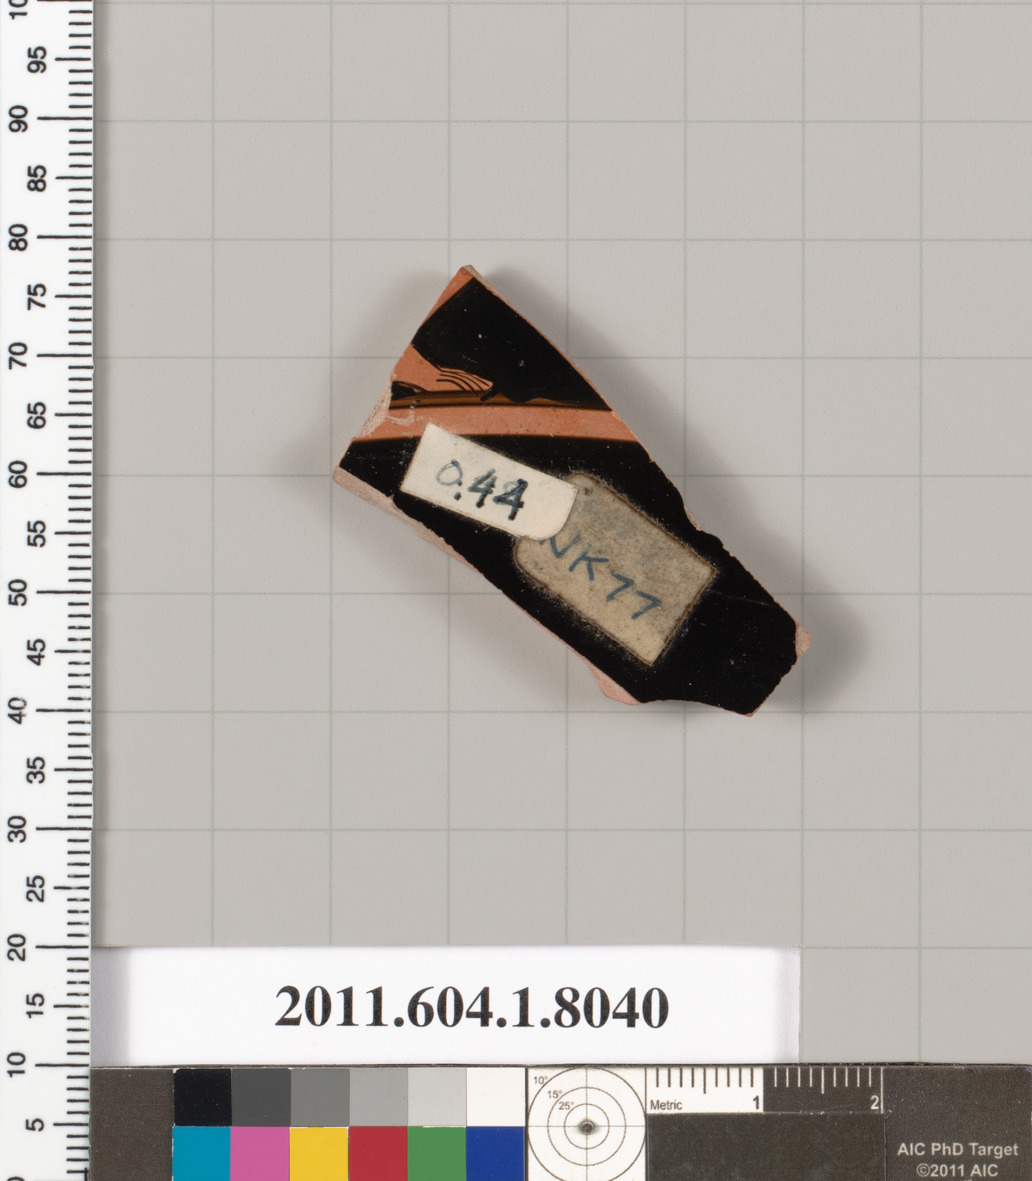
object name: kylix fragment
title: Terracotta fragment of a kylix (drinking cup)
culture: greek, attic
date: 510-500 BCE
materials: terracotta